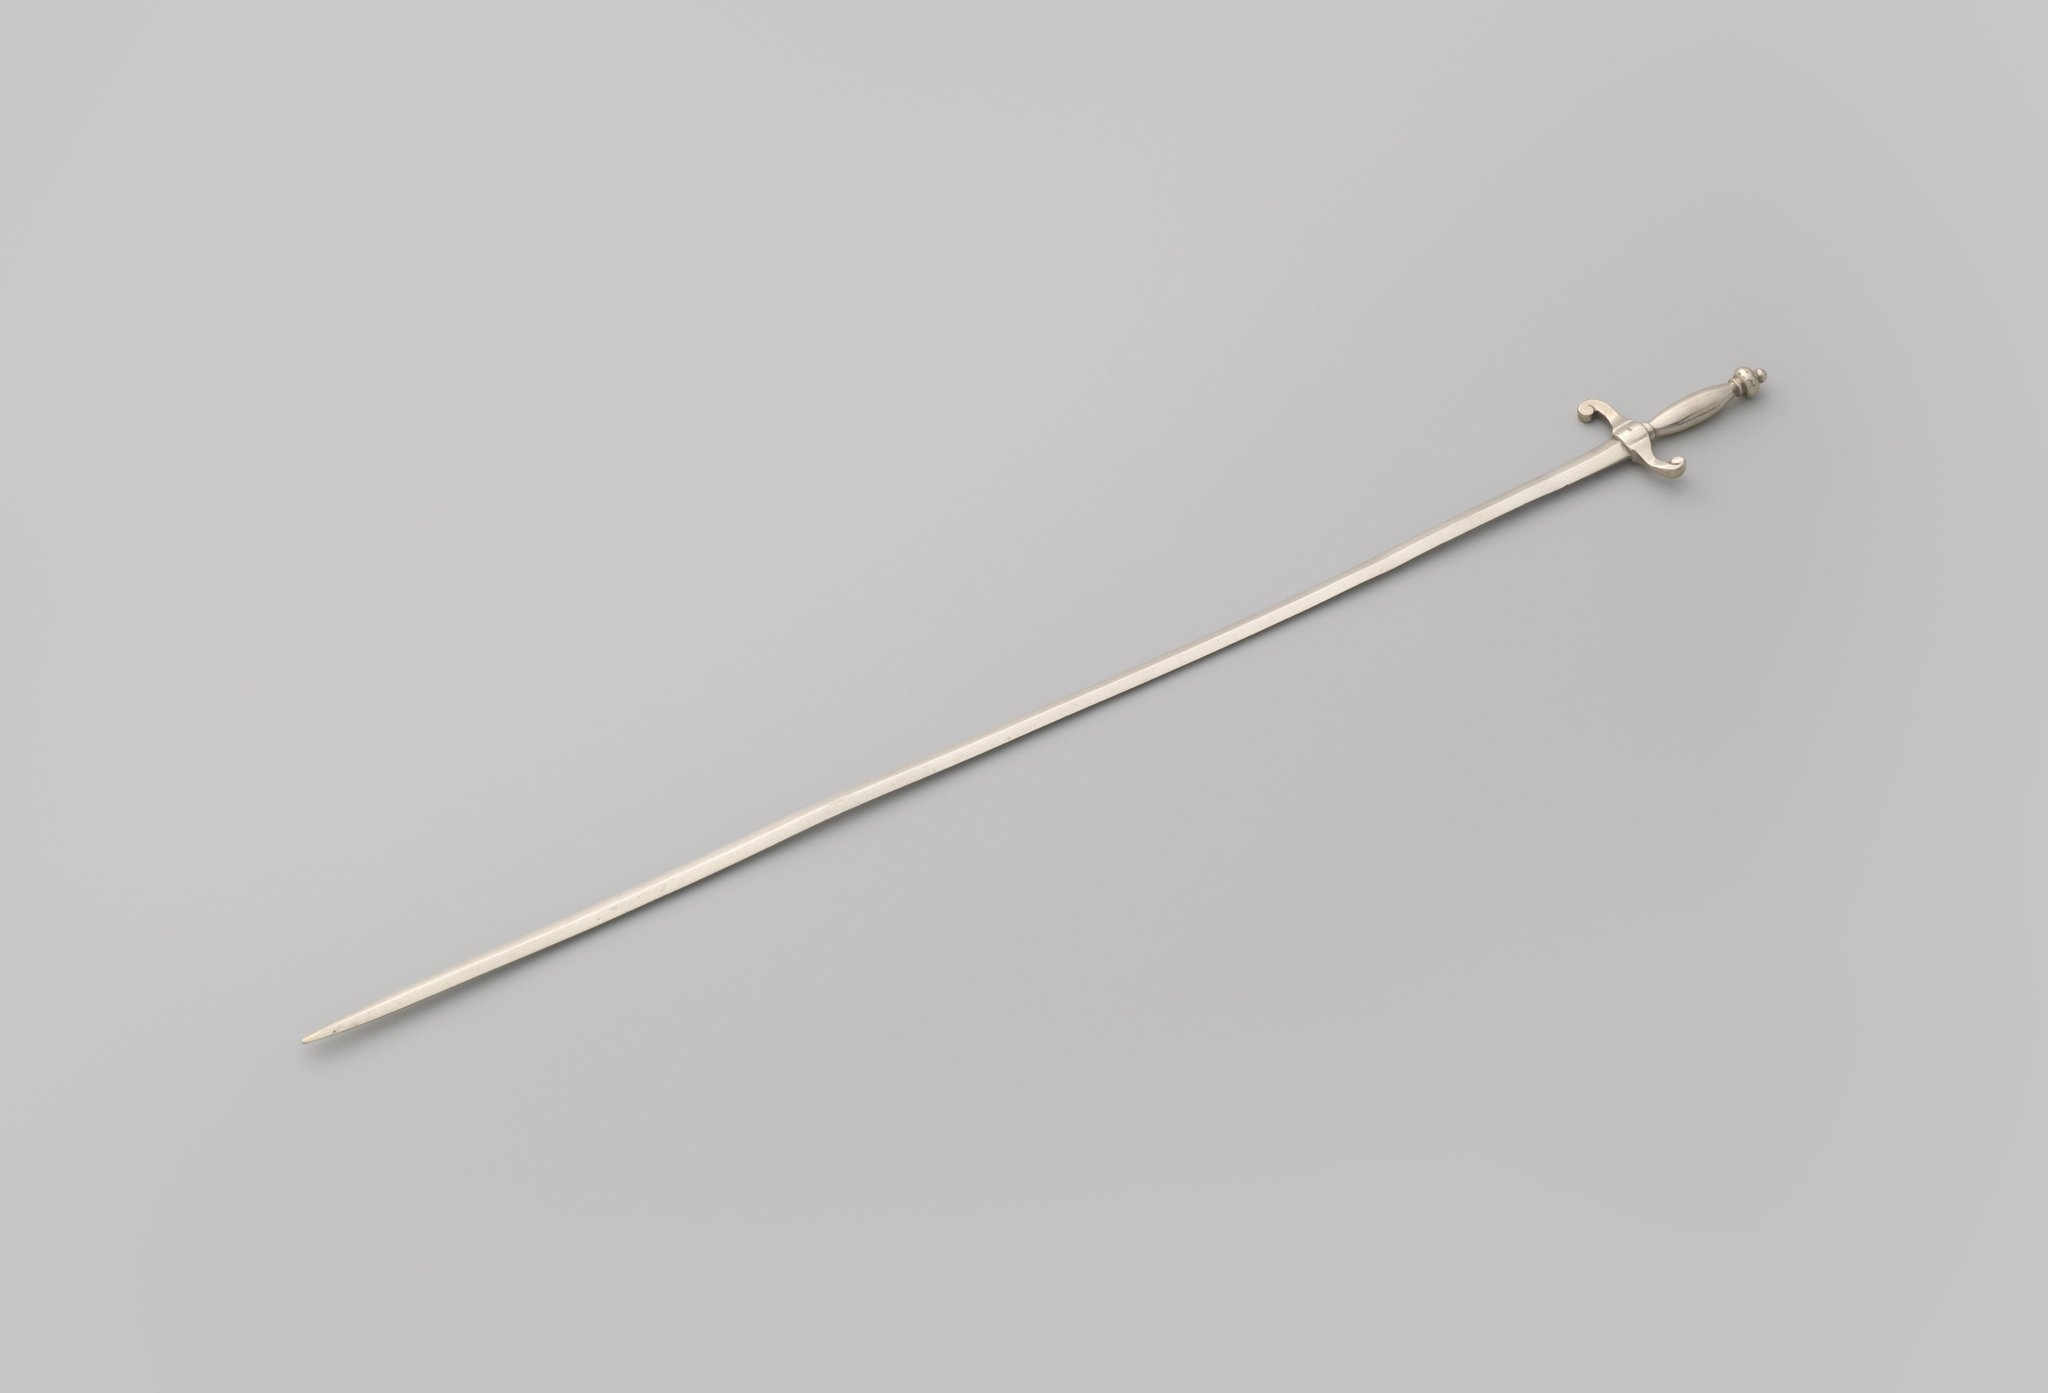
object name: skewer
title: Vleespen in de vorm van een degen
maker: johannes schiotling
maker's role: silversmith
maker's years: 1730-1799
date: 1791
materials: silver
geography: amsterdam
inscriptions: : ‘ZII’, maker's mark, date letter: ‘G’, town mark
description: De vleespennen (A en B) hebben de vorm van een degen met een lang lemmet en een gevest dat bestaat uit een uit twee voluten opgebouwde pareerstang, een langgerekt ovale greep en een bolvormige knop, bekroond door een klein knopje.